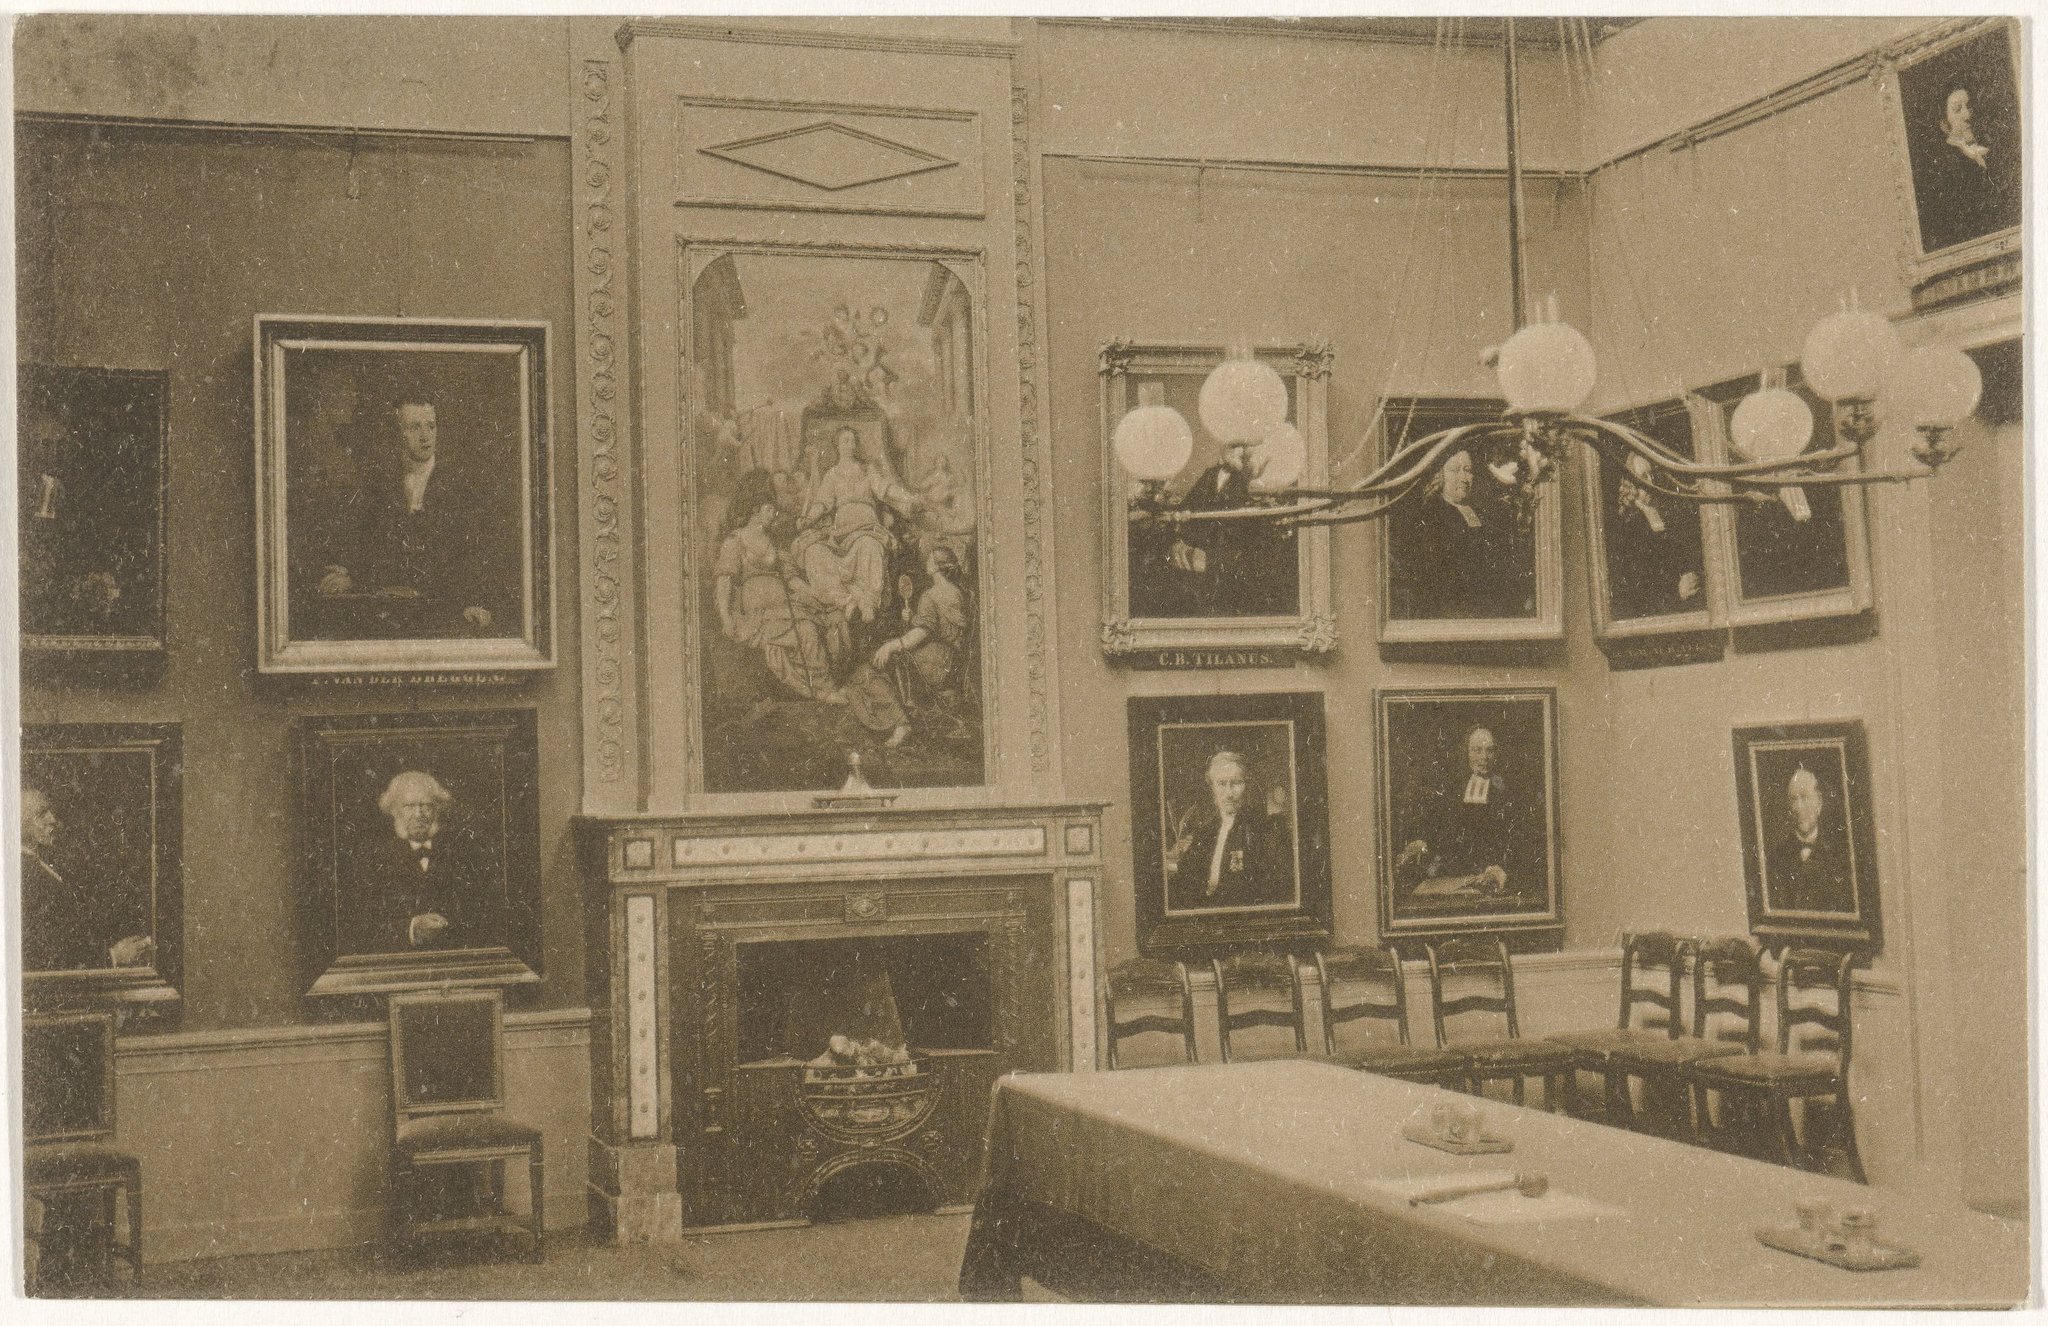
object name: ansichtkaart, prentbriefkaart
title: Universiteit van Amsterdam, klein auditorium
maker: Anonymous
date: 1907-1930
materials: cardboard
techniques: photograph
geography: amsterdam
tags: university building, college